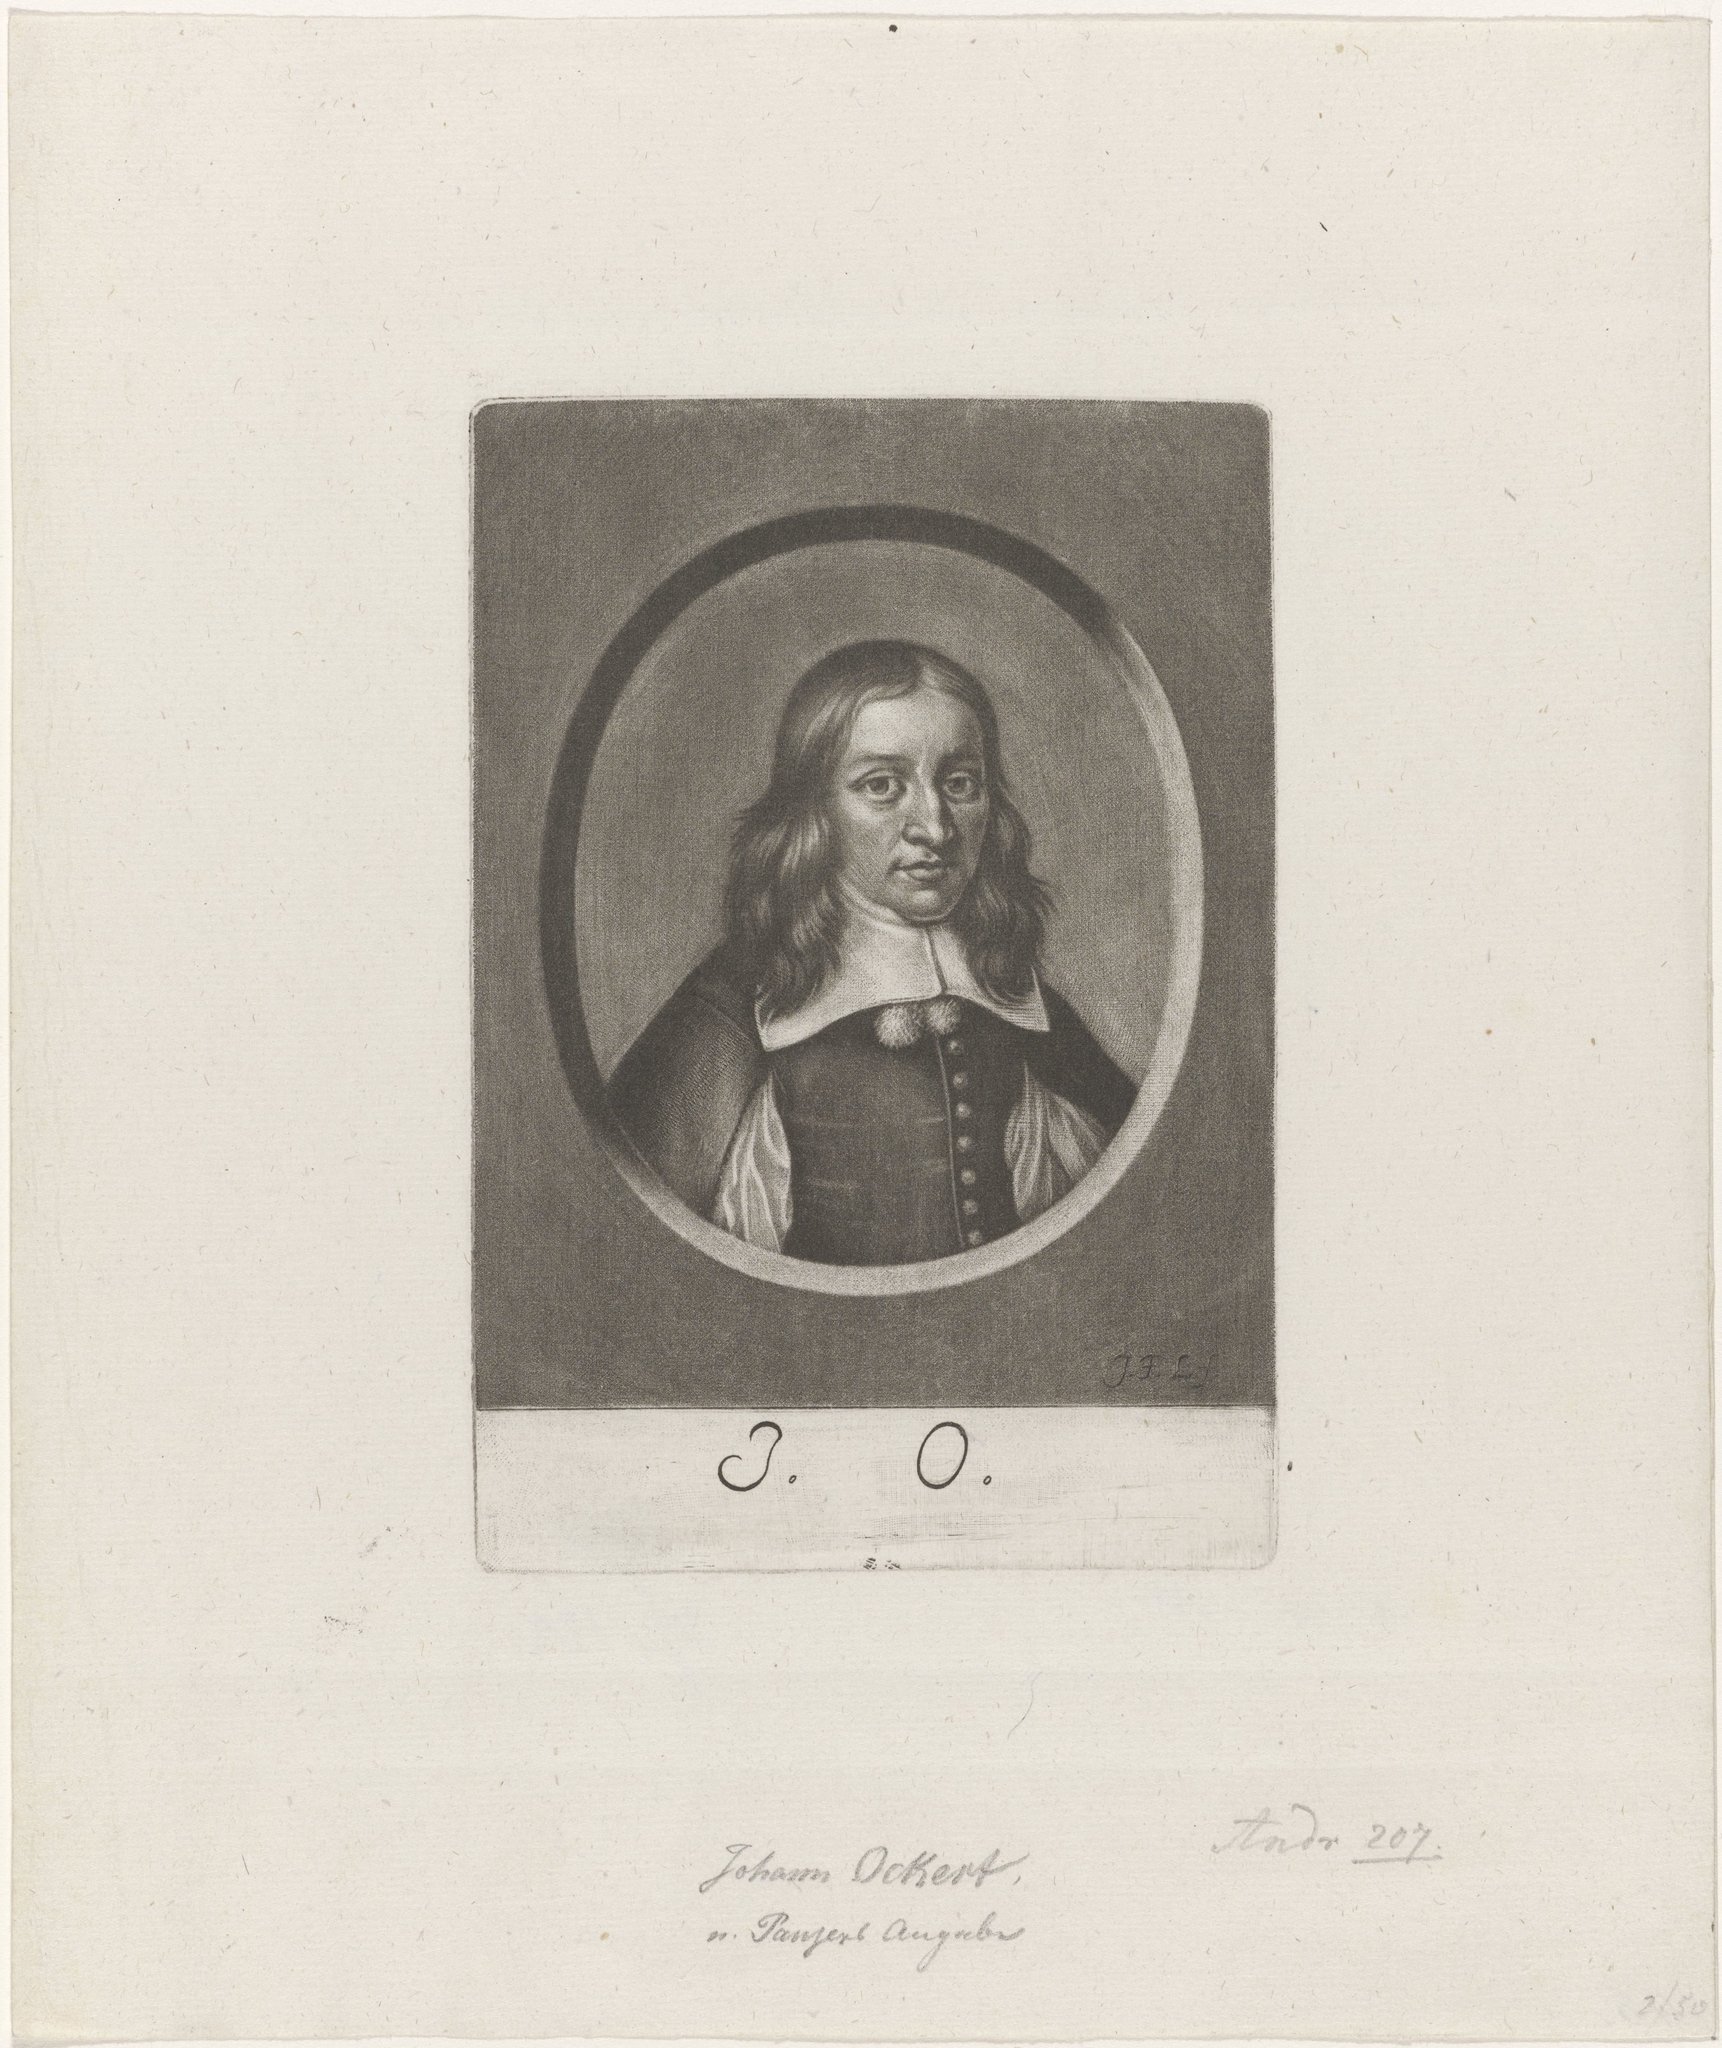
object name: print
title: Portret van Johann Ockert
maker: johann friedrich leonard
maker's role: print maker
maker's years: 1633-1680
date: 1643-1680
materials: paper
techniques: mezzotint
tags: johann ockert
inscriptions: collector's mark: Lugt 2166